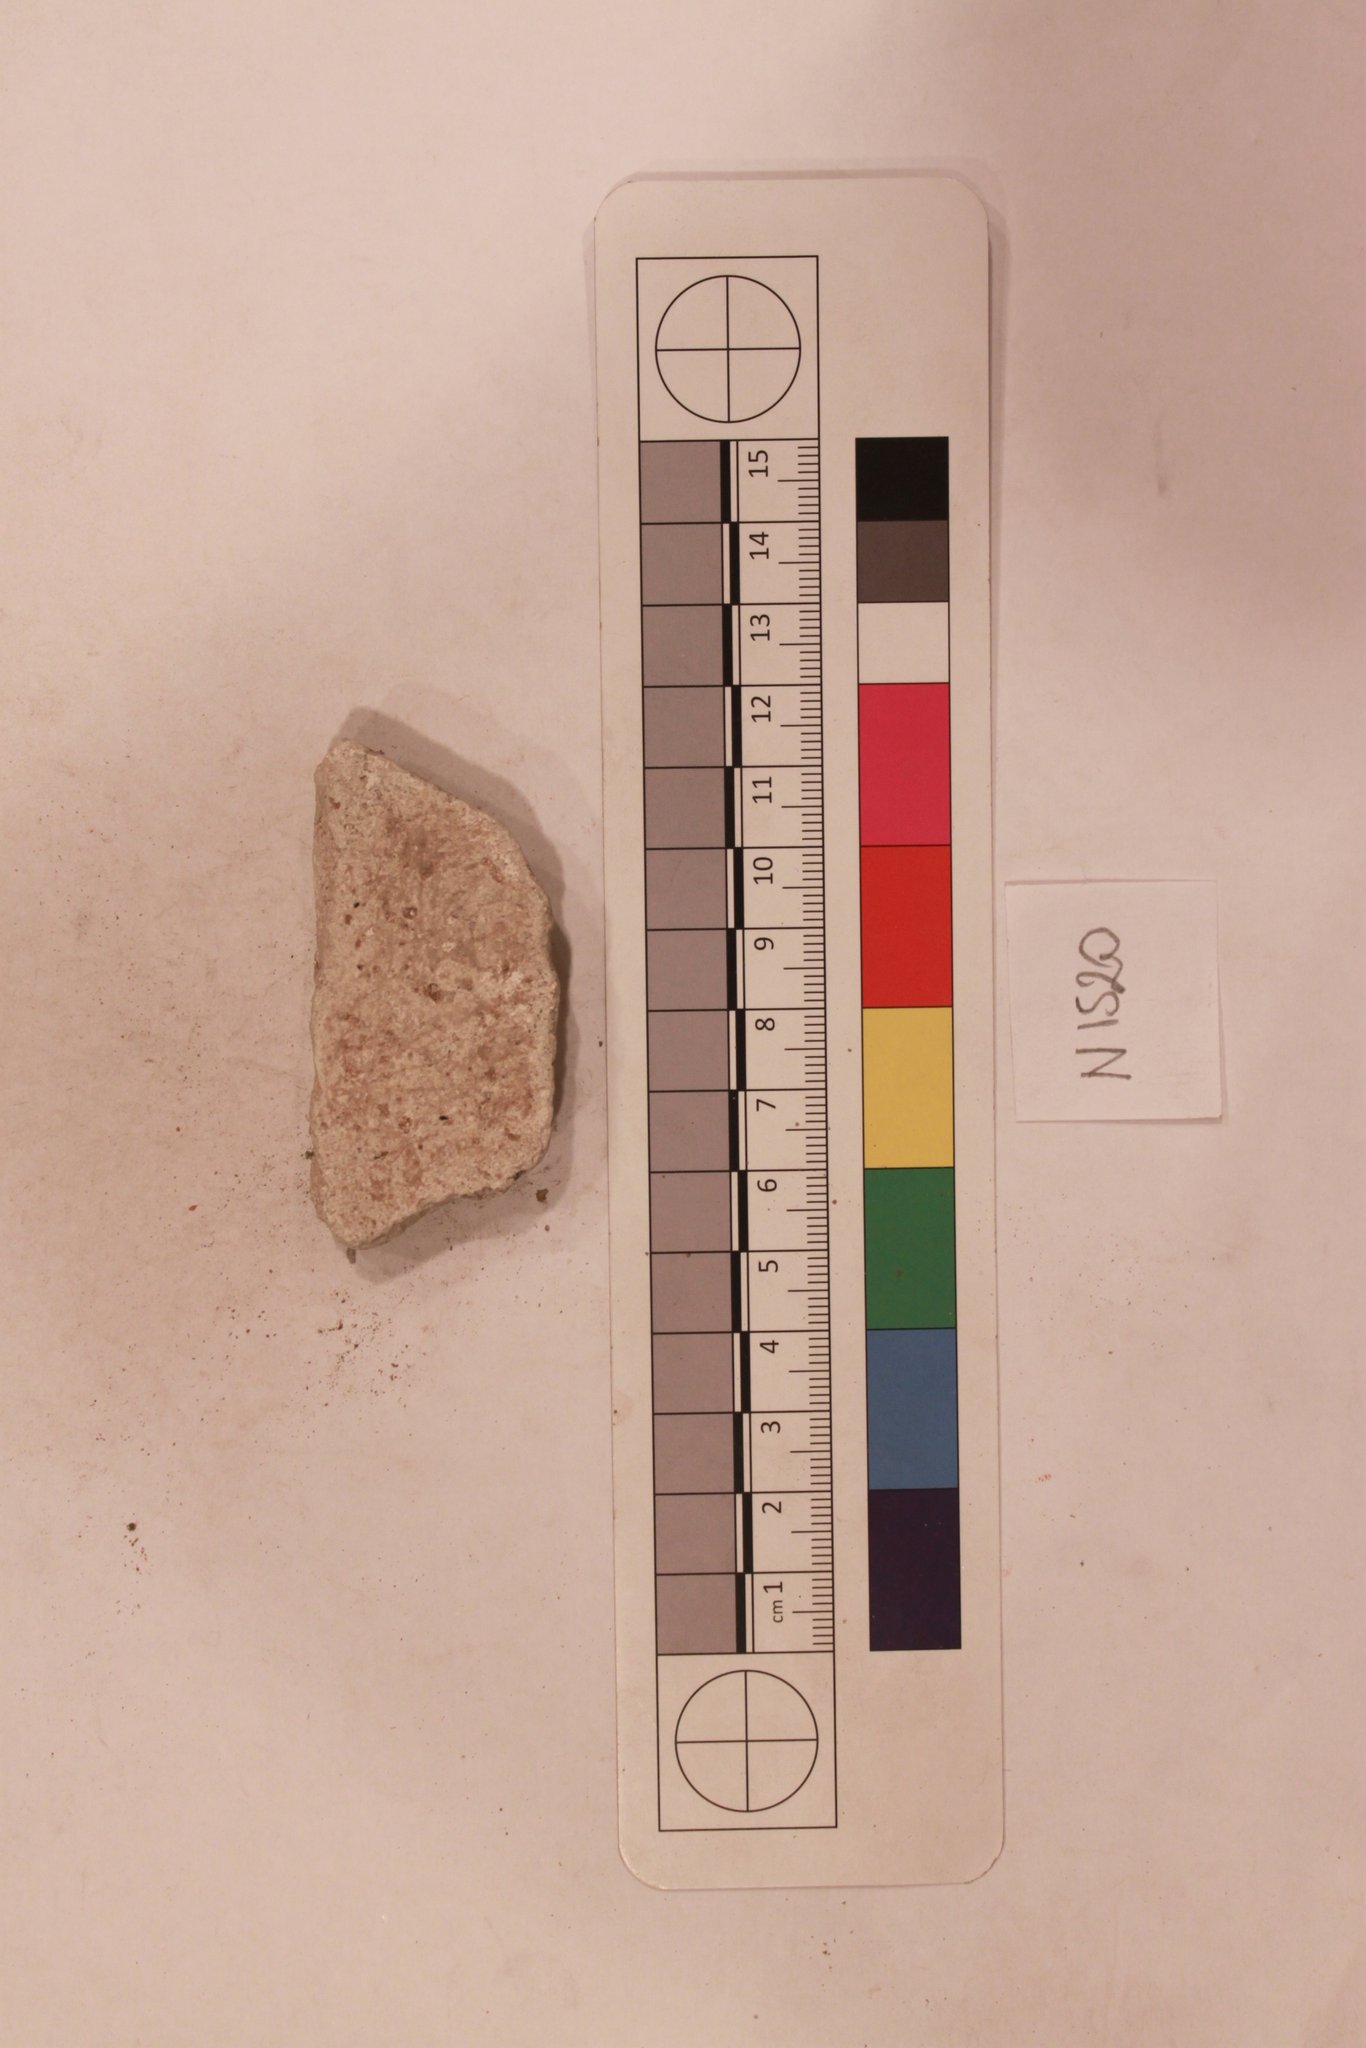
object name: fragment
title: Stucco Fragment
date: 701-1200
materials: plaster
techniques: carving, painting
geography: iran